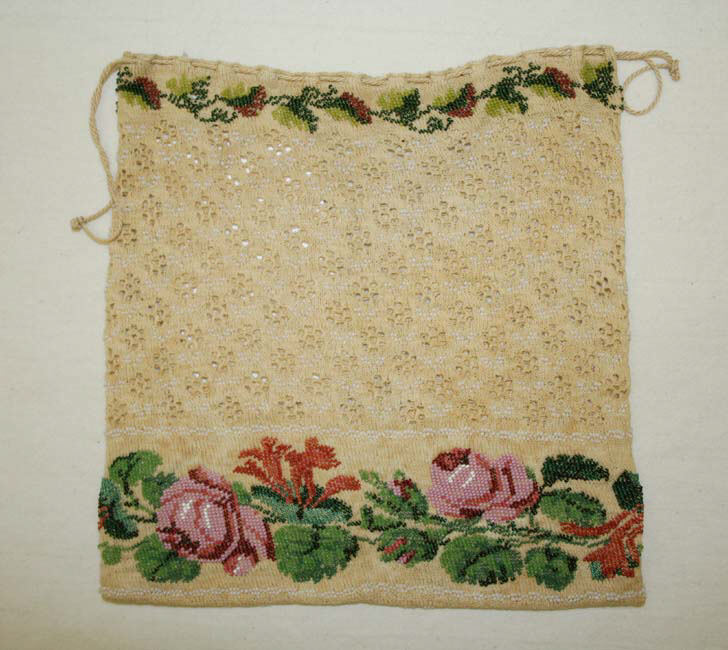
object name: drawstring bag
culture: french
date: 1810-1820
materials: cotton, glass